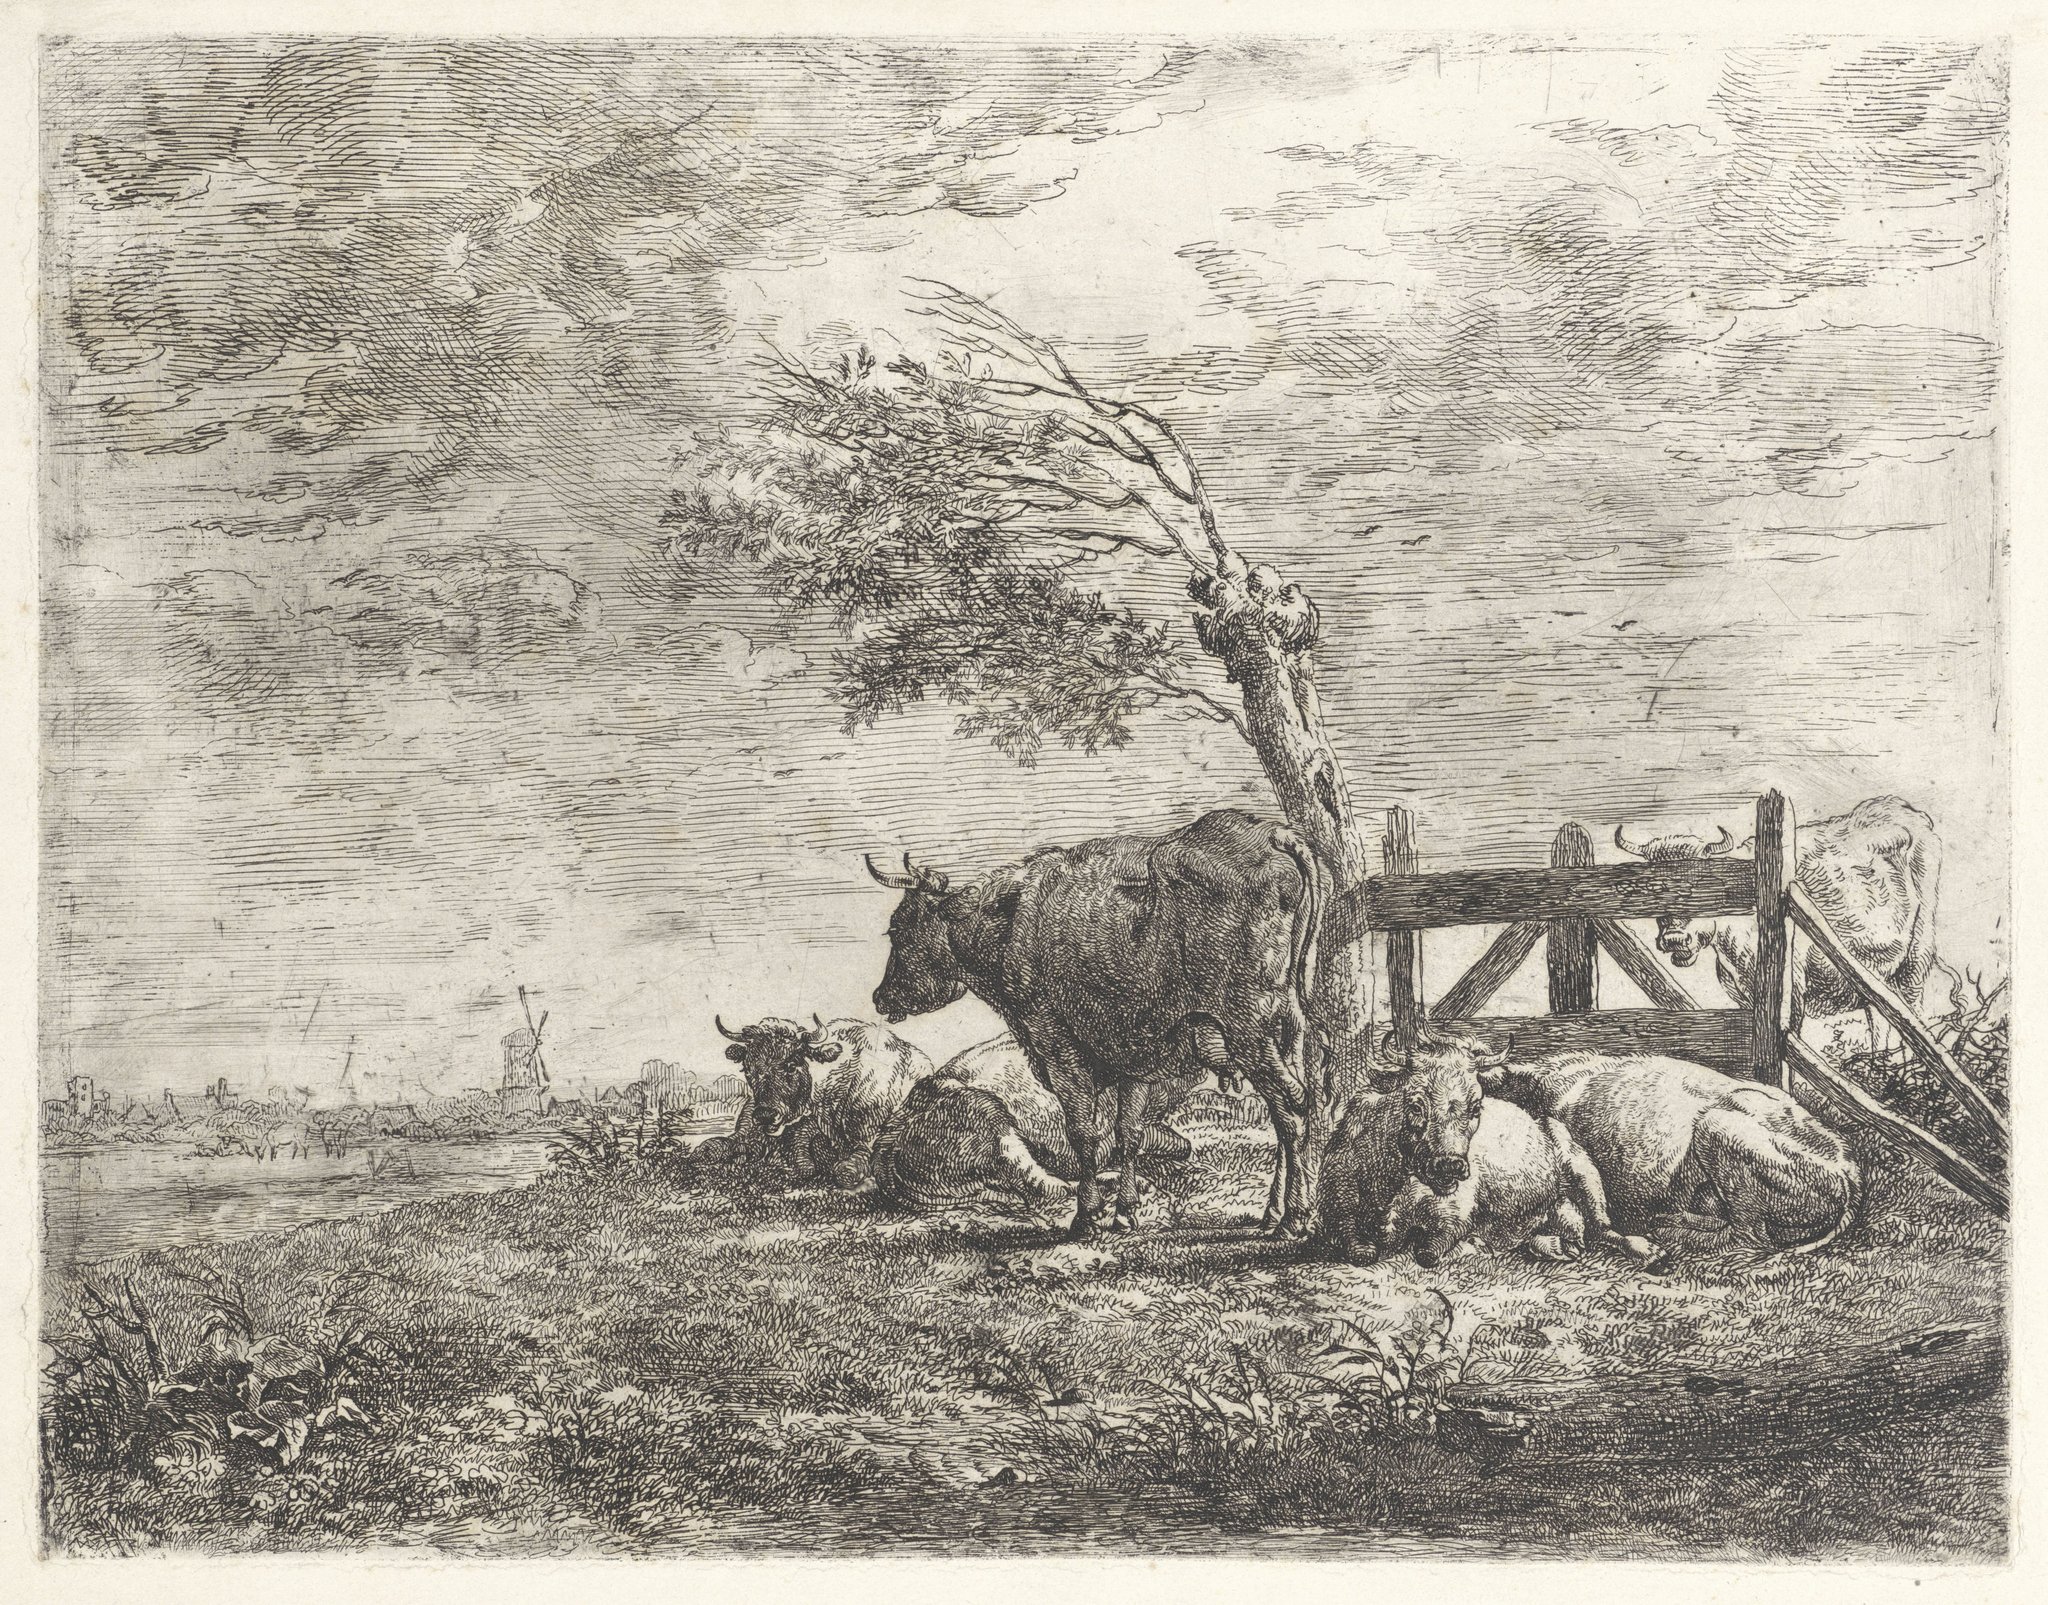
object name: print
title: Koeien bij een hek en een knotwilg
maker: albertus verhoesen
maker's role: draughtsman, painter, print maker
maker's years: 1806-1881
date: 1816-1881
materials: paper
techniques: etching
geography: netherlands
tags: cow, meadow, pasture, windmill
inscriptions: collector's mark: Lugt 2228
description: Een landschap met koeien bij een hek en een knotwilg. Links een rivier en aan de horizon een molen.